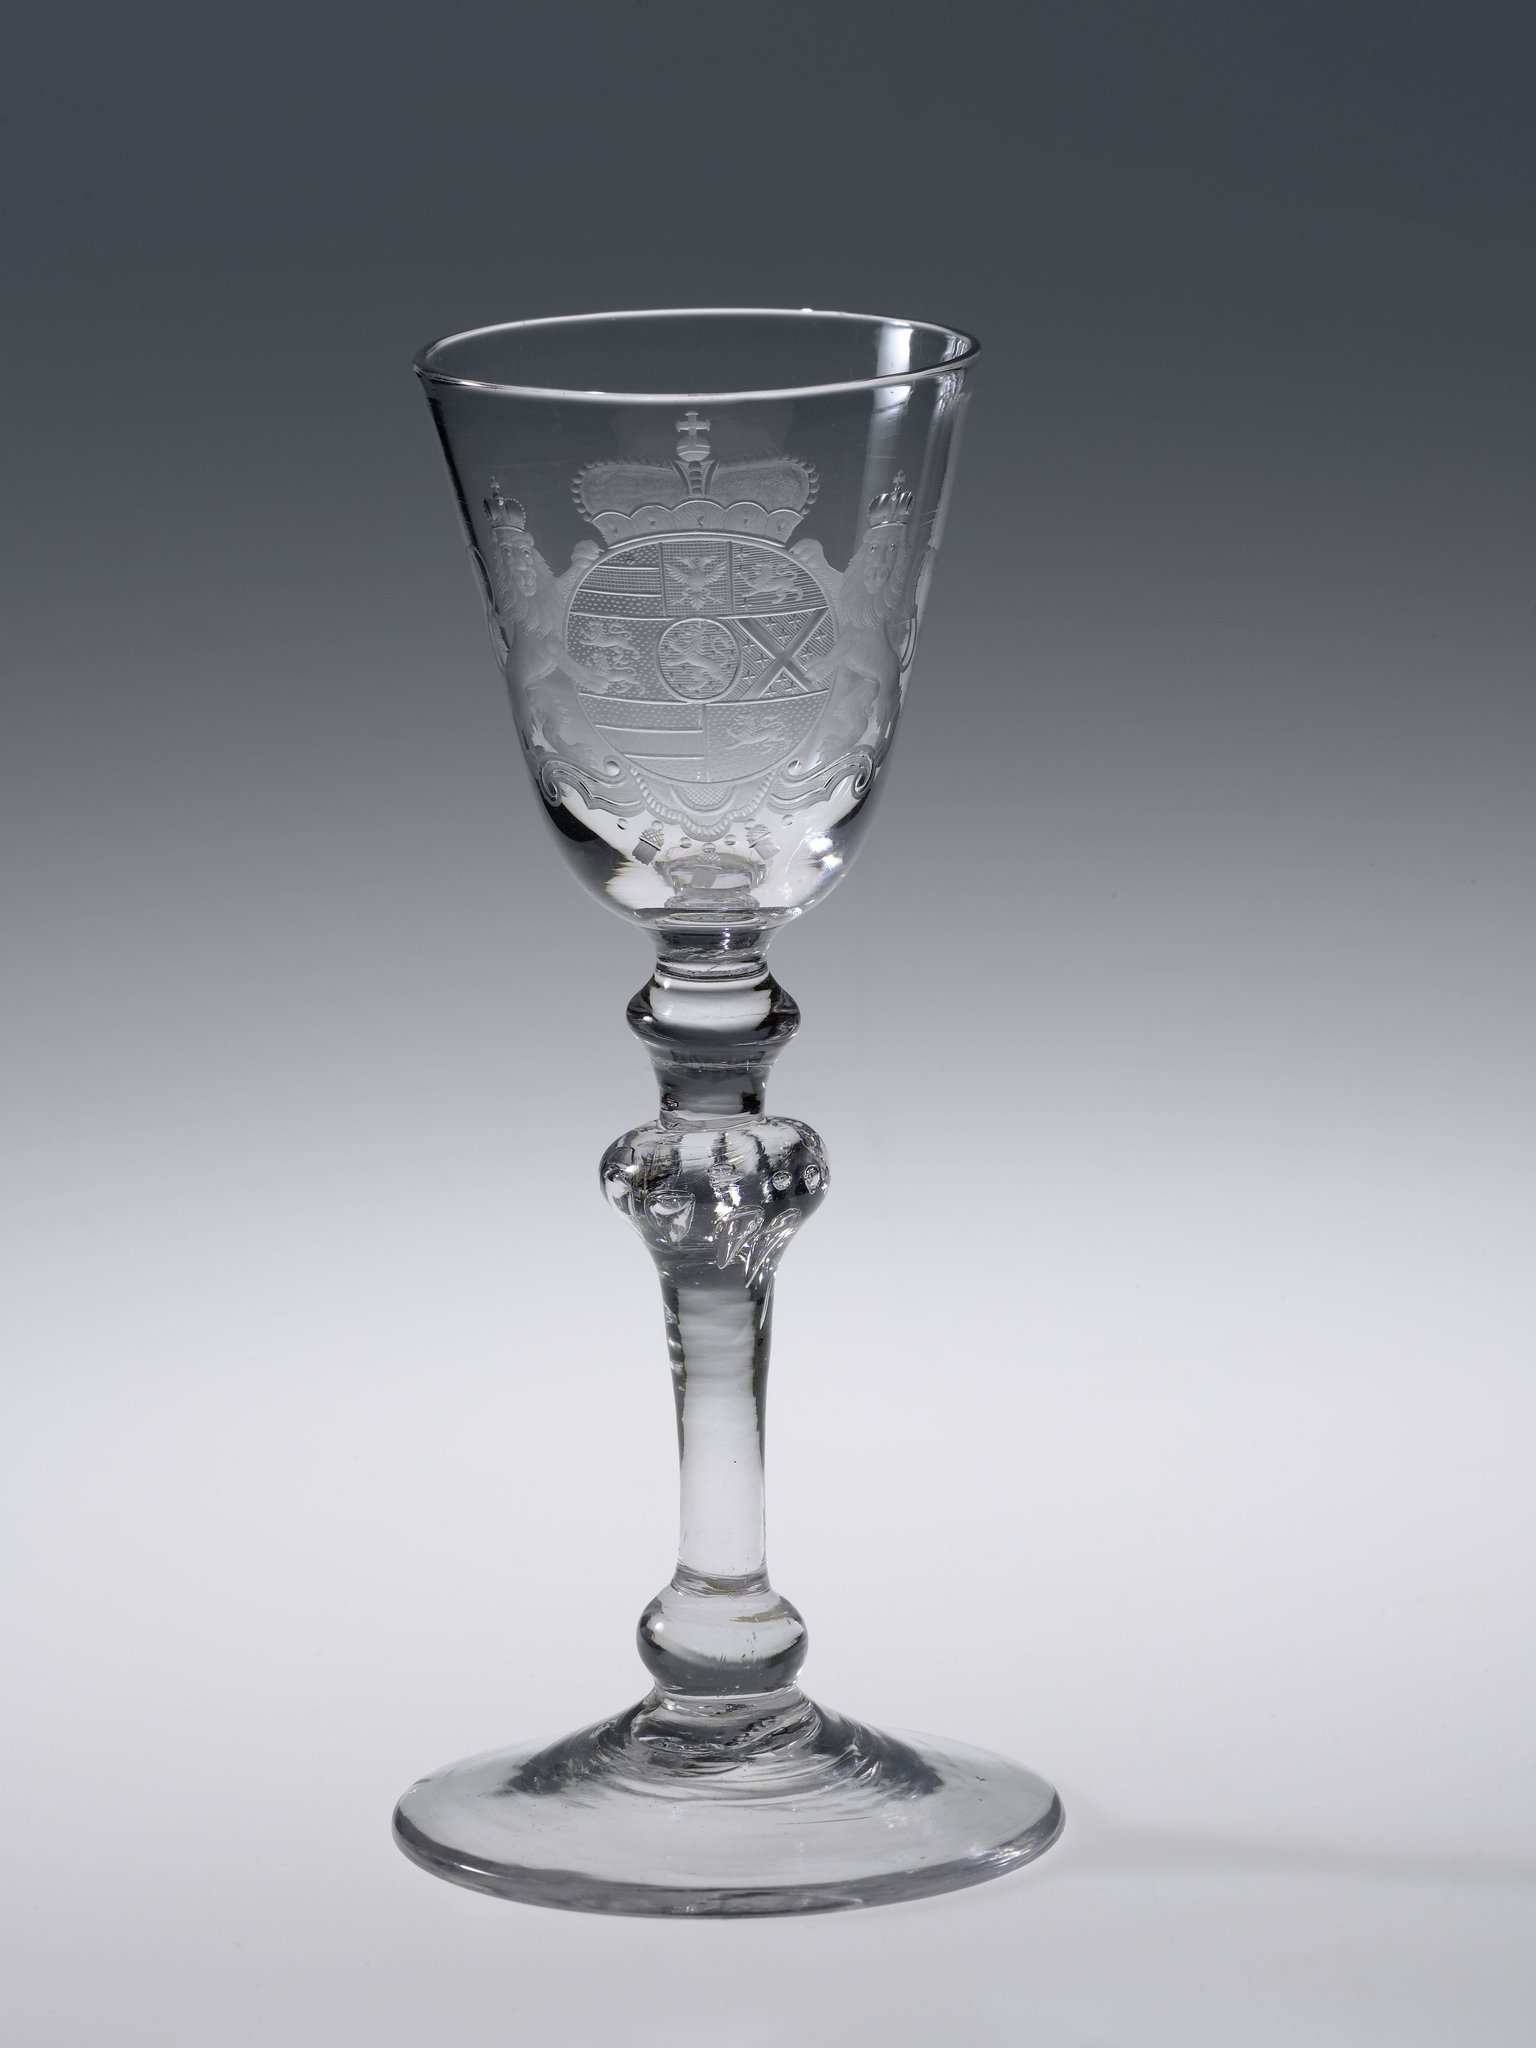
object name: goblet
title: Kelkglas met het wapen van Karel Christiaan, prins van Nassau Weilburg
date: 1760-1775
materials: glass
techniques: glassblowing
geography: low countries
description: Coat of arms of Charles Christian, Prince of Nassau-Weilburg. A.J. Enschedé bequest, 1896.